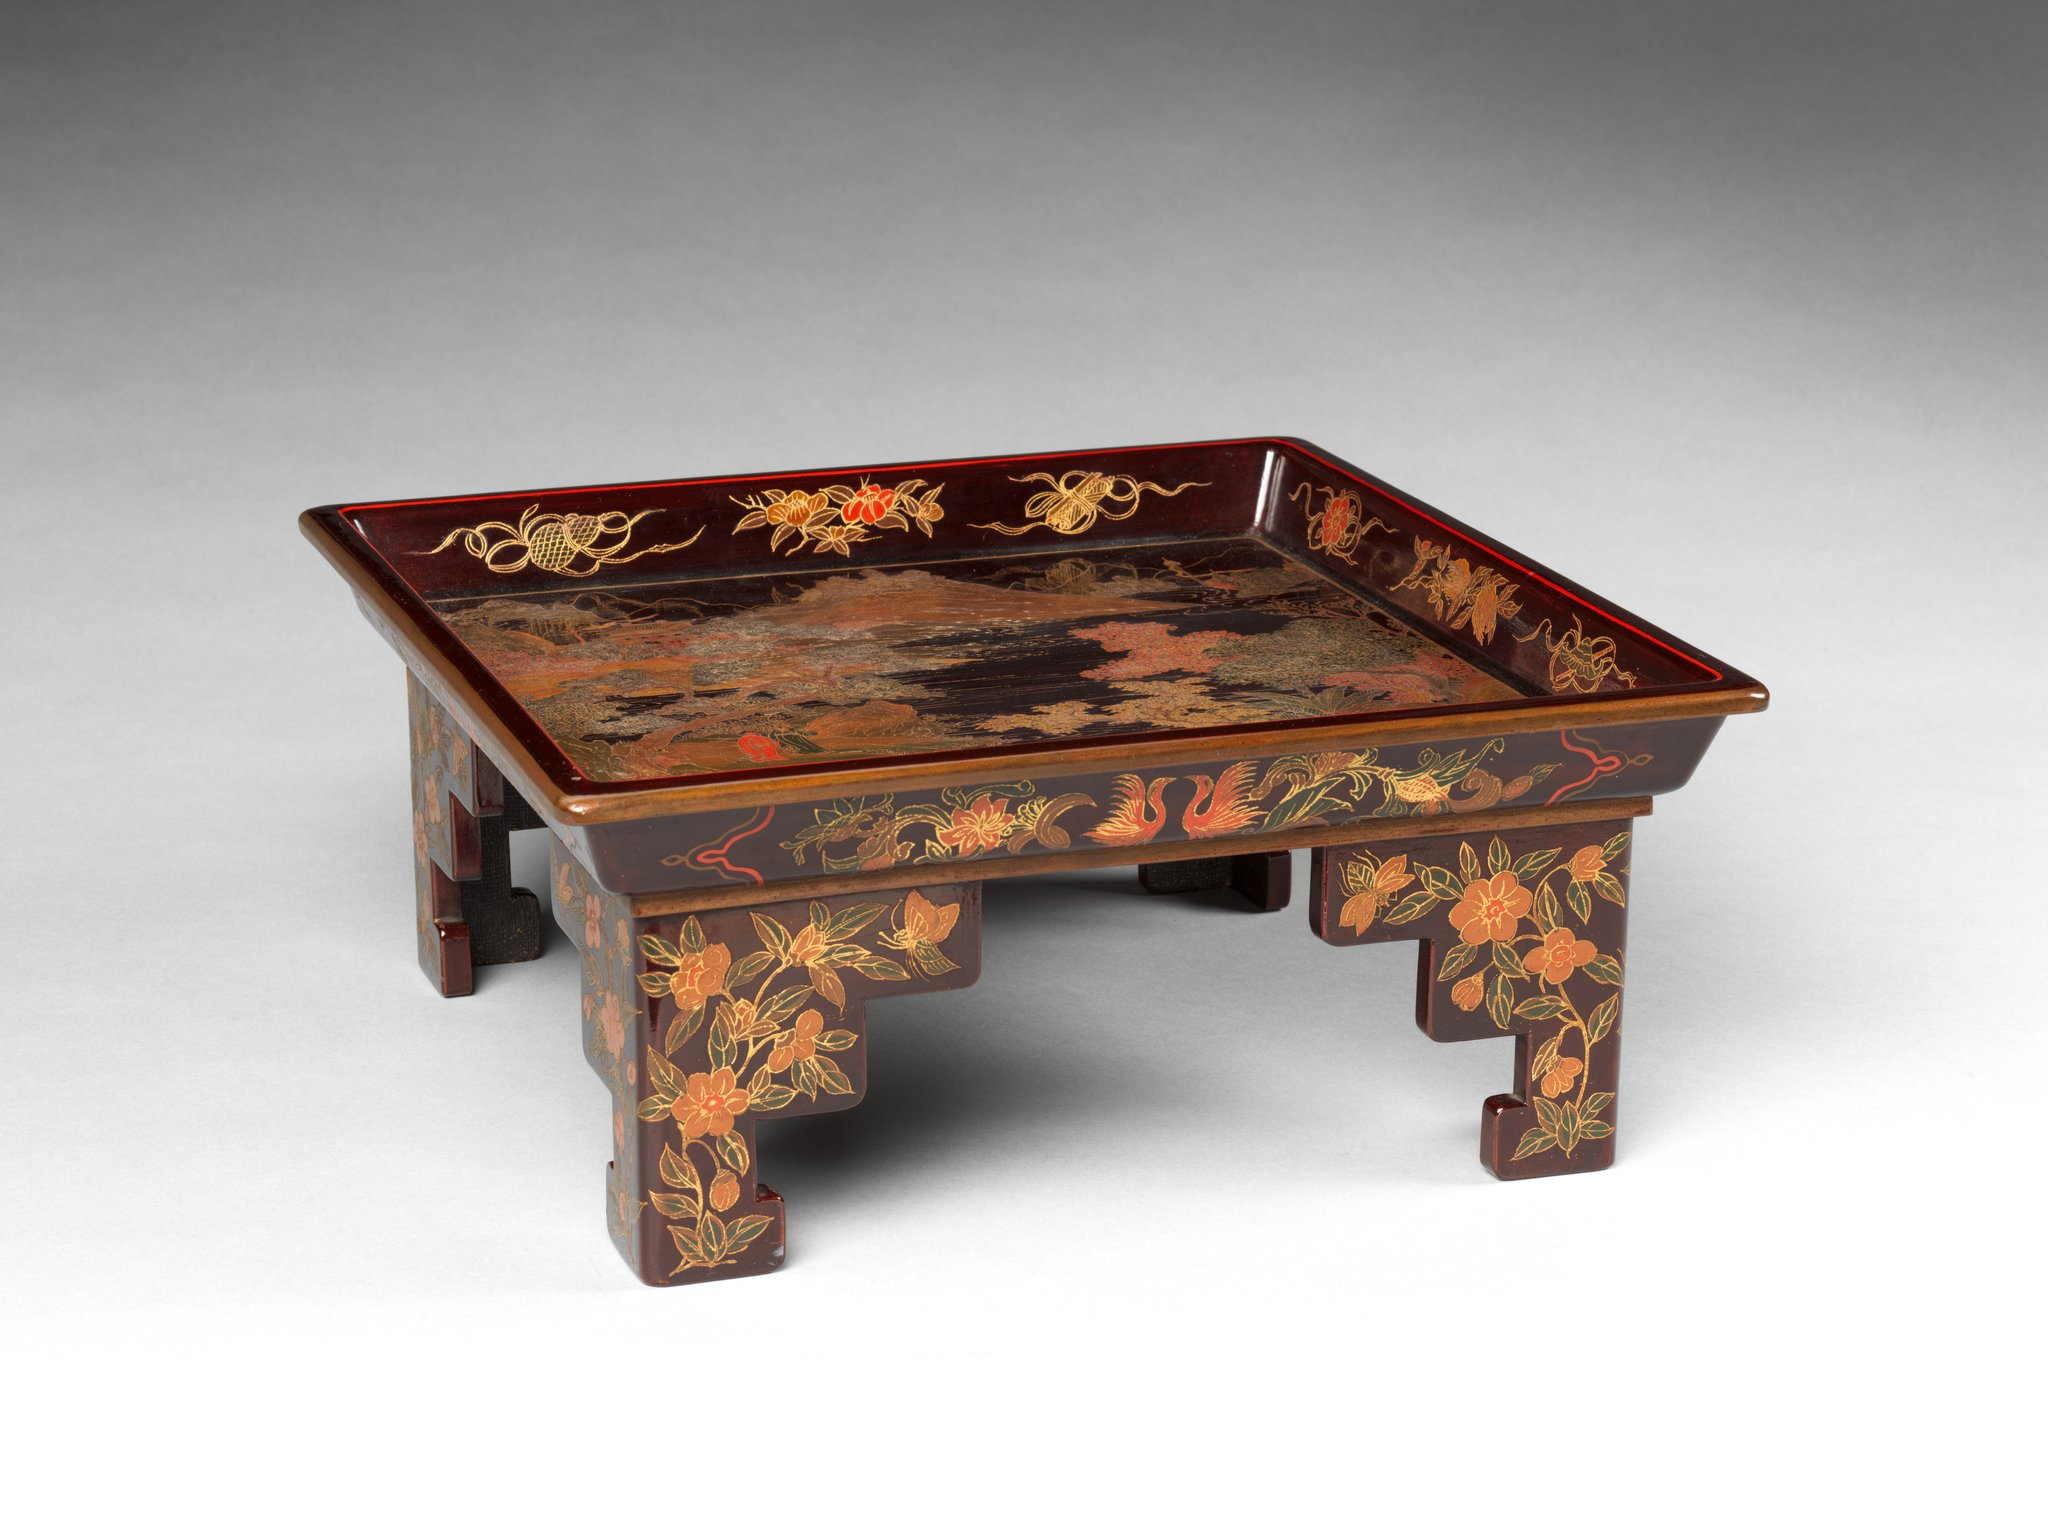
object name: food stand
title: Food stand with decoration of figures in a landscape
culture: japanese or ryukyuan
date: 1701-1900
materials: gold, lacquer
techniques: painting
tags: landscapes